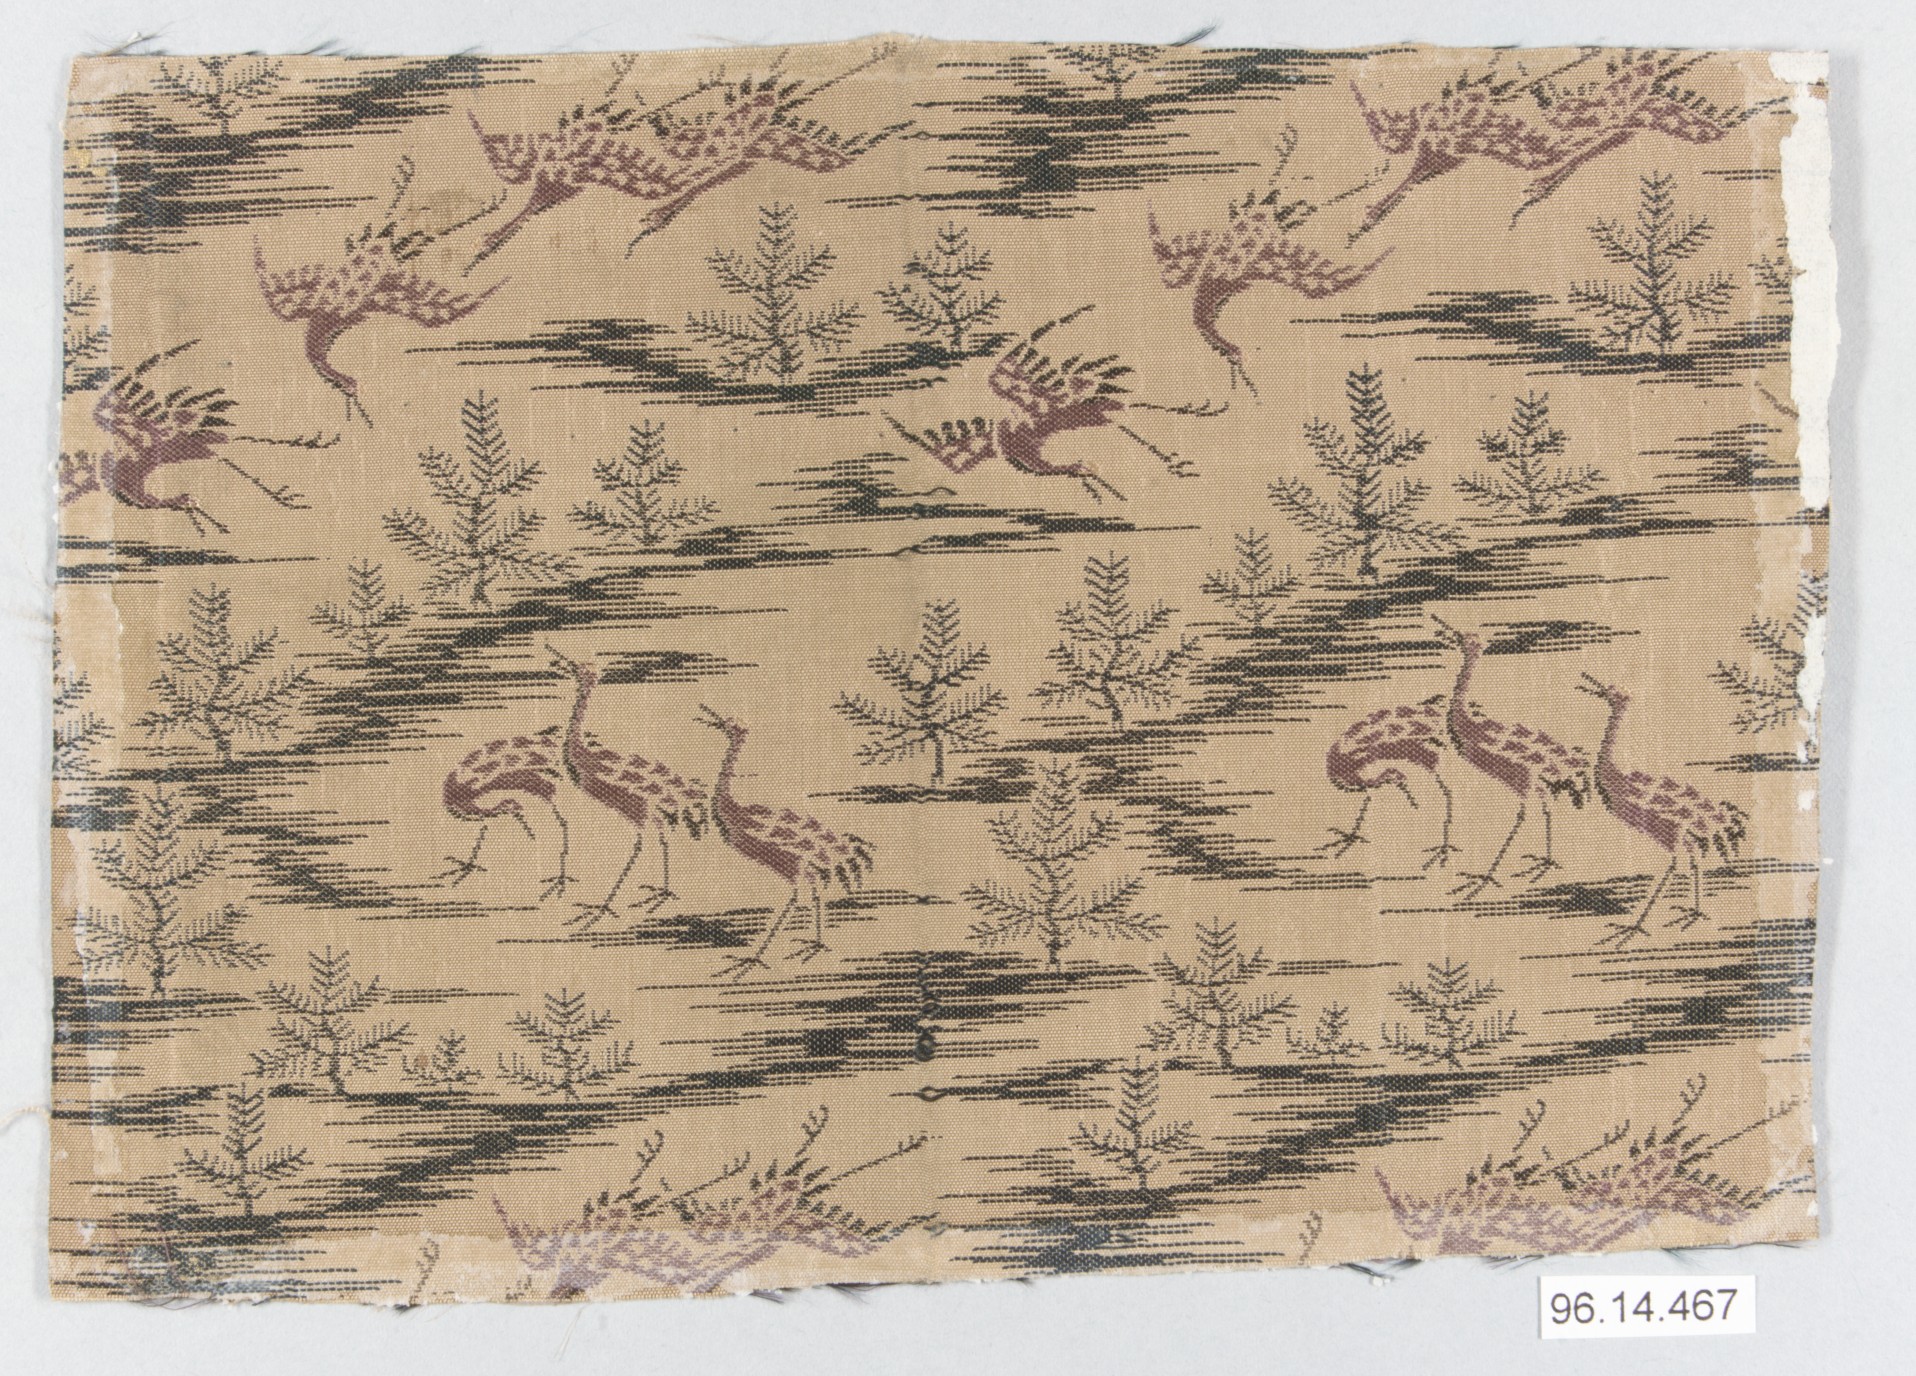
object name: piece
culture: japanese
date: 1701-1900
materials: silk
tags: cranes